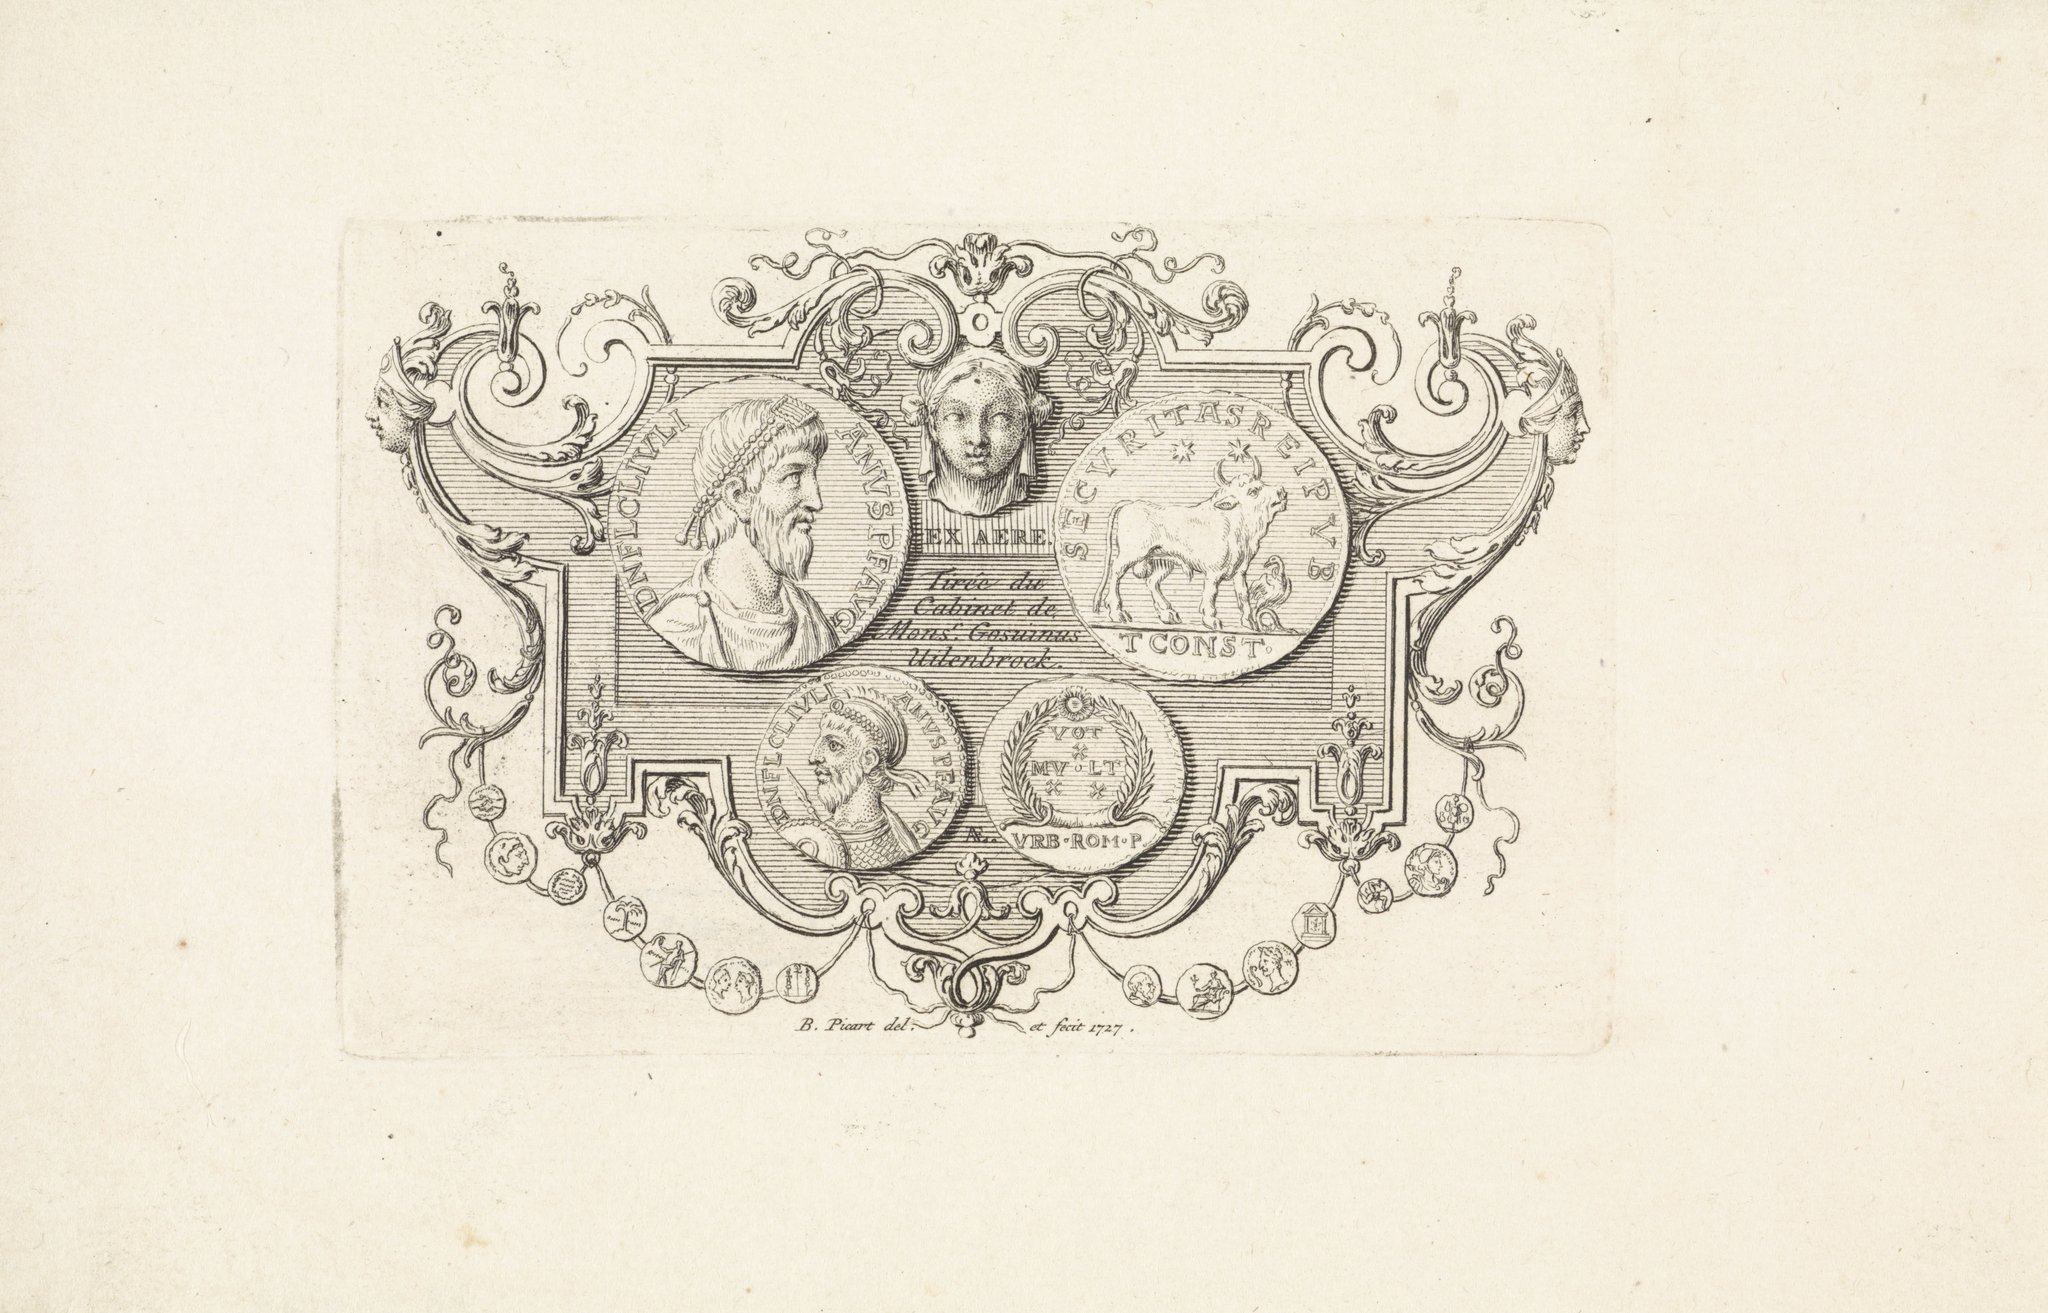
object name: ornament print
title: Vier penningen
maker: bernard picart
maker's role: draughtsman, print maker, publisher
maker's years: 1673-1733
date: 1727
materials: paper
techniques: engraving, etching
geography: amsterdam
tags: ornaments ~ art, coin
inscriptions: collector's mark: Lugt 2228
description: Prent gebruikt in: Flavius Claudius Julianus Apostata. Les cesars. [Vertaald uit het Grieks door] Ezechiel Spanheim. Amsterdam: François L'Honoré, 1728, p. XLII.